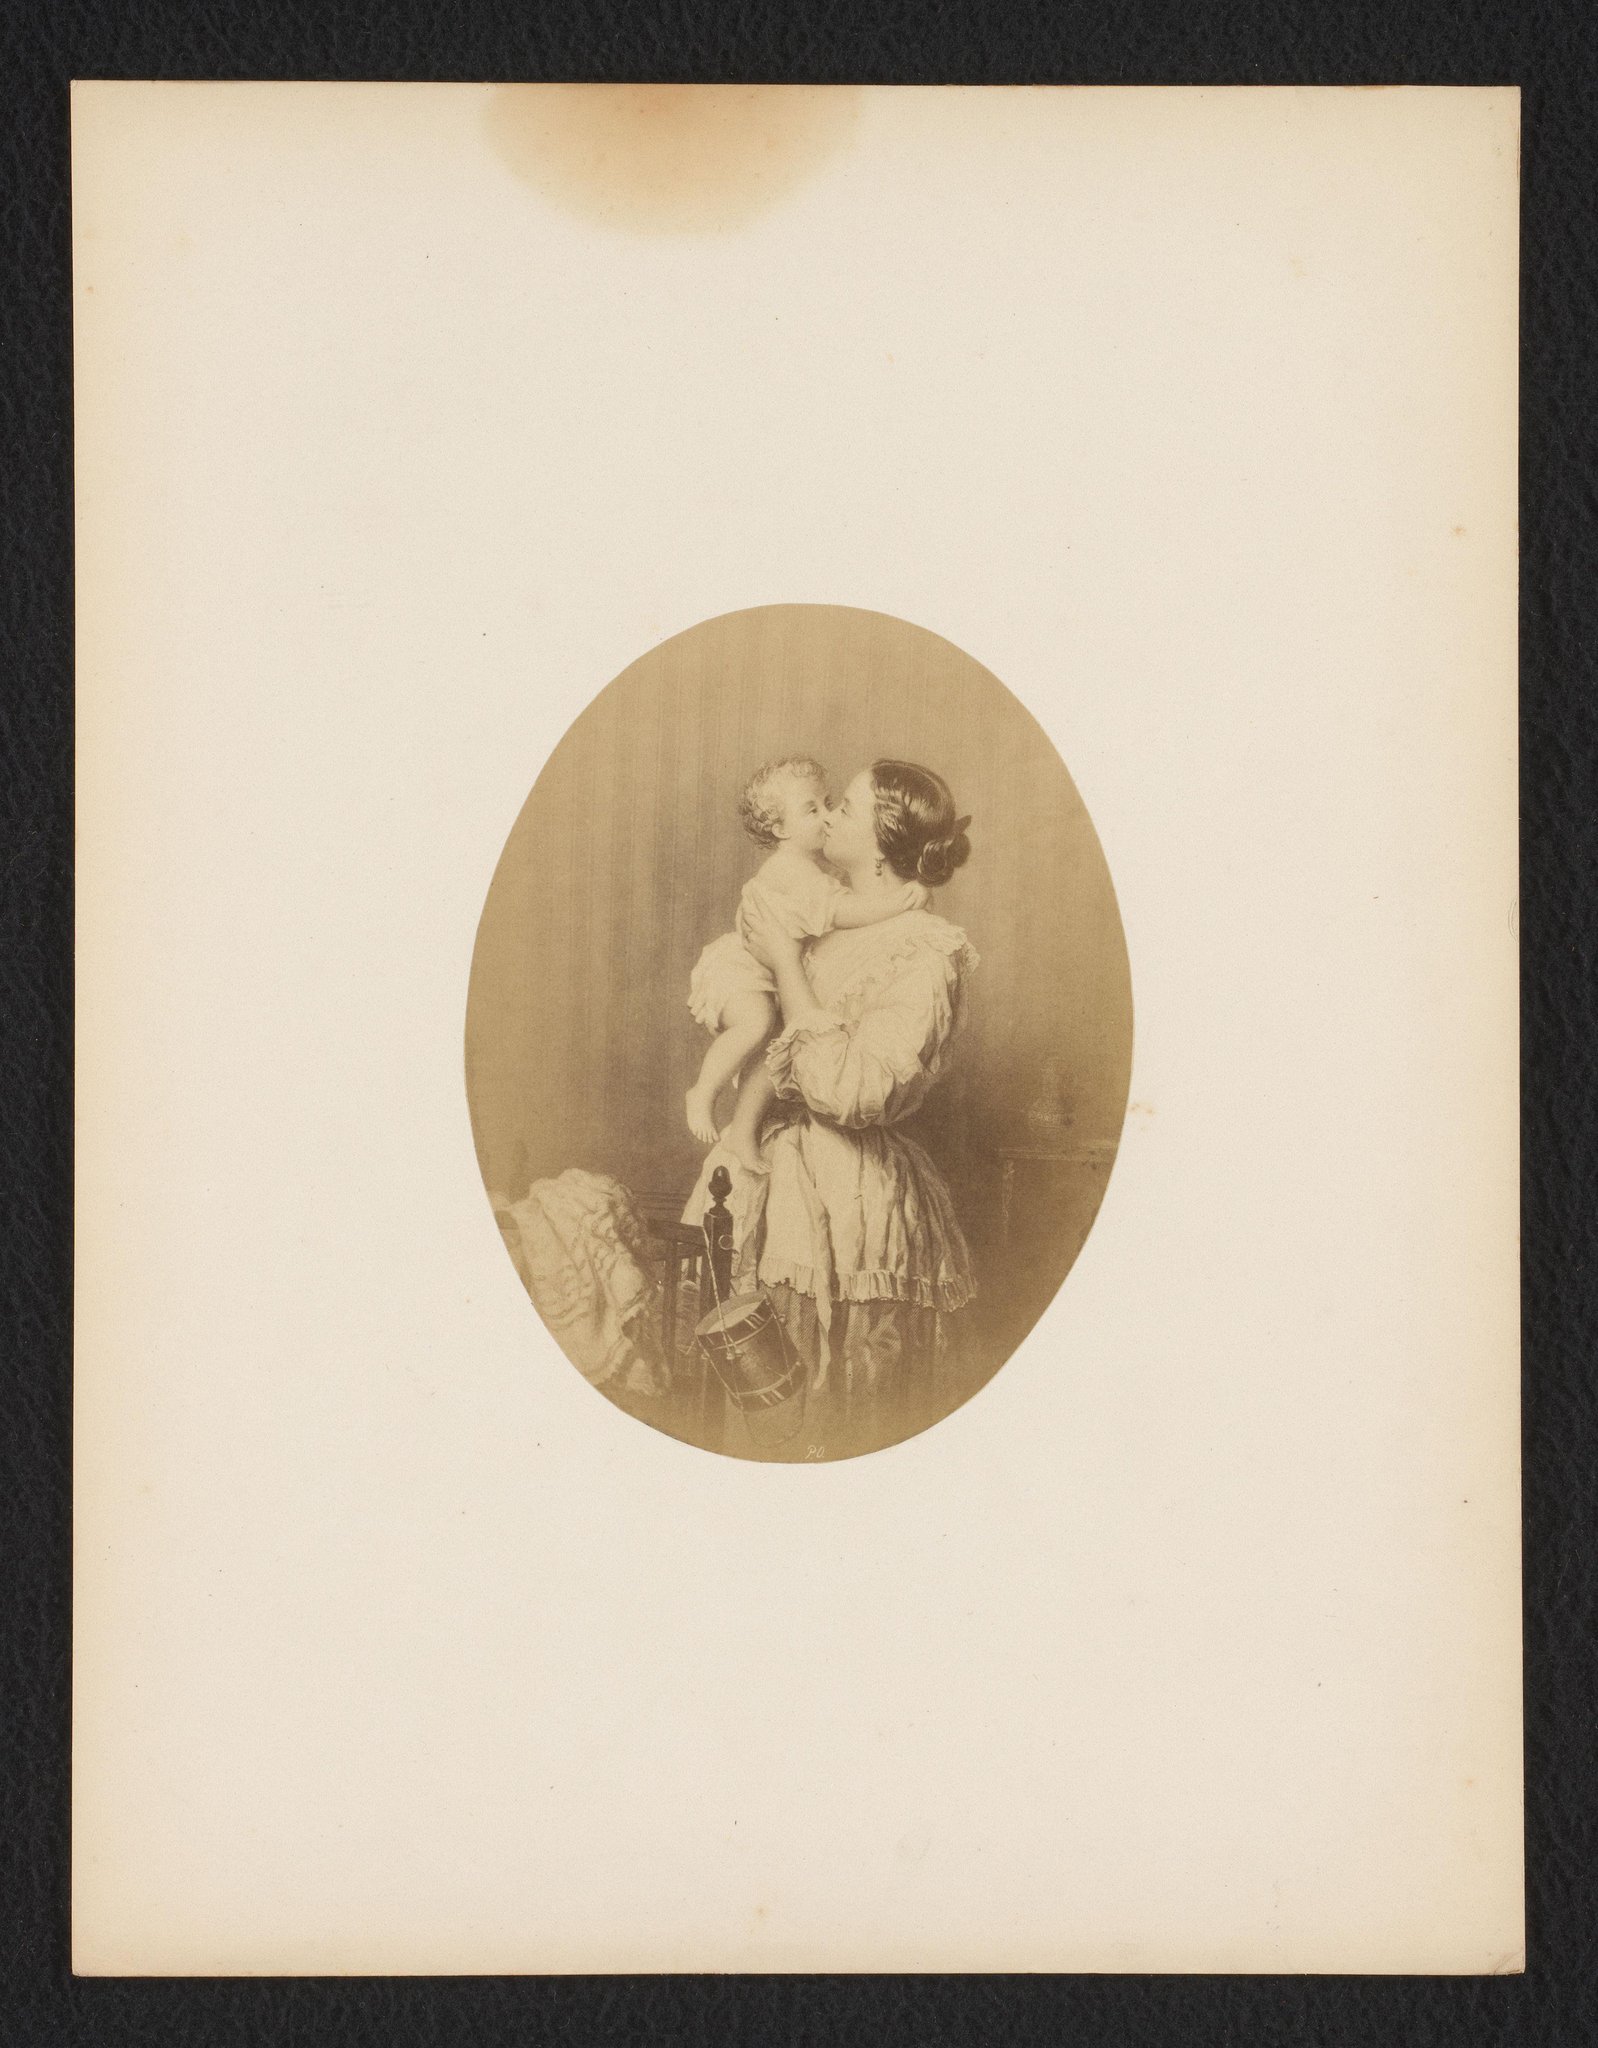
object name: photograph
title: Fotoreproductie van het schilderij Birthday naar Adolphe Dubasty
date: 1860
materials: cardboard, paper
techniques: albumen print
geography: amsterdam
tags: picture, painting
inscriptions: monogram: ‘P.O.’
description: Deze foto maakt deel uit van een omslag.